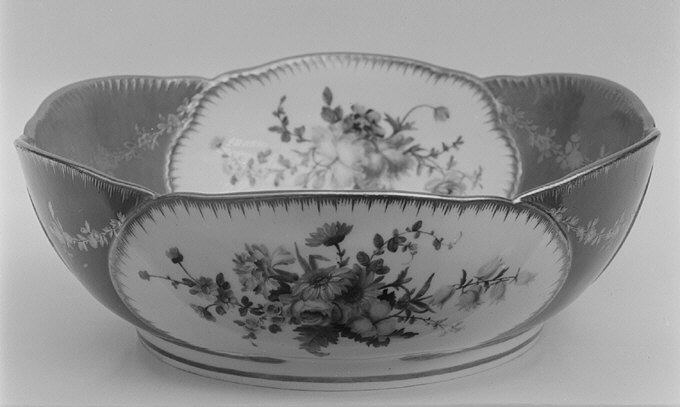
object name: salad bowl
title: Salad bowl (saladier) (one of six) (part of a service)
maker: sèvres manufactory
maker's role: manufactory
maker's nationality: french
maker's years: 1740-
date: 1771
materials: soft paste porcelain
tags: flowers